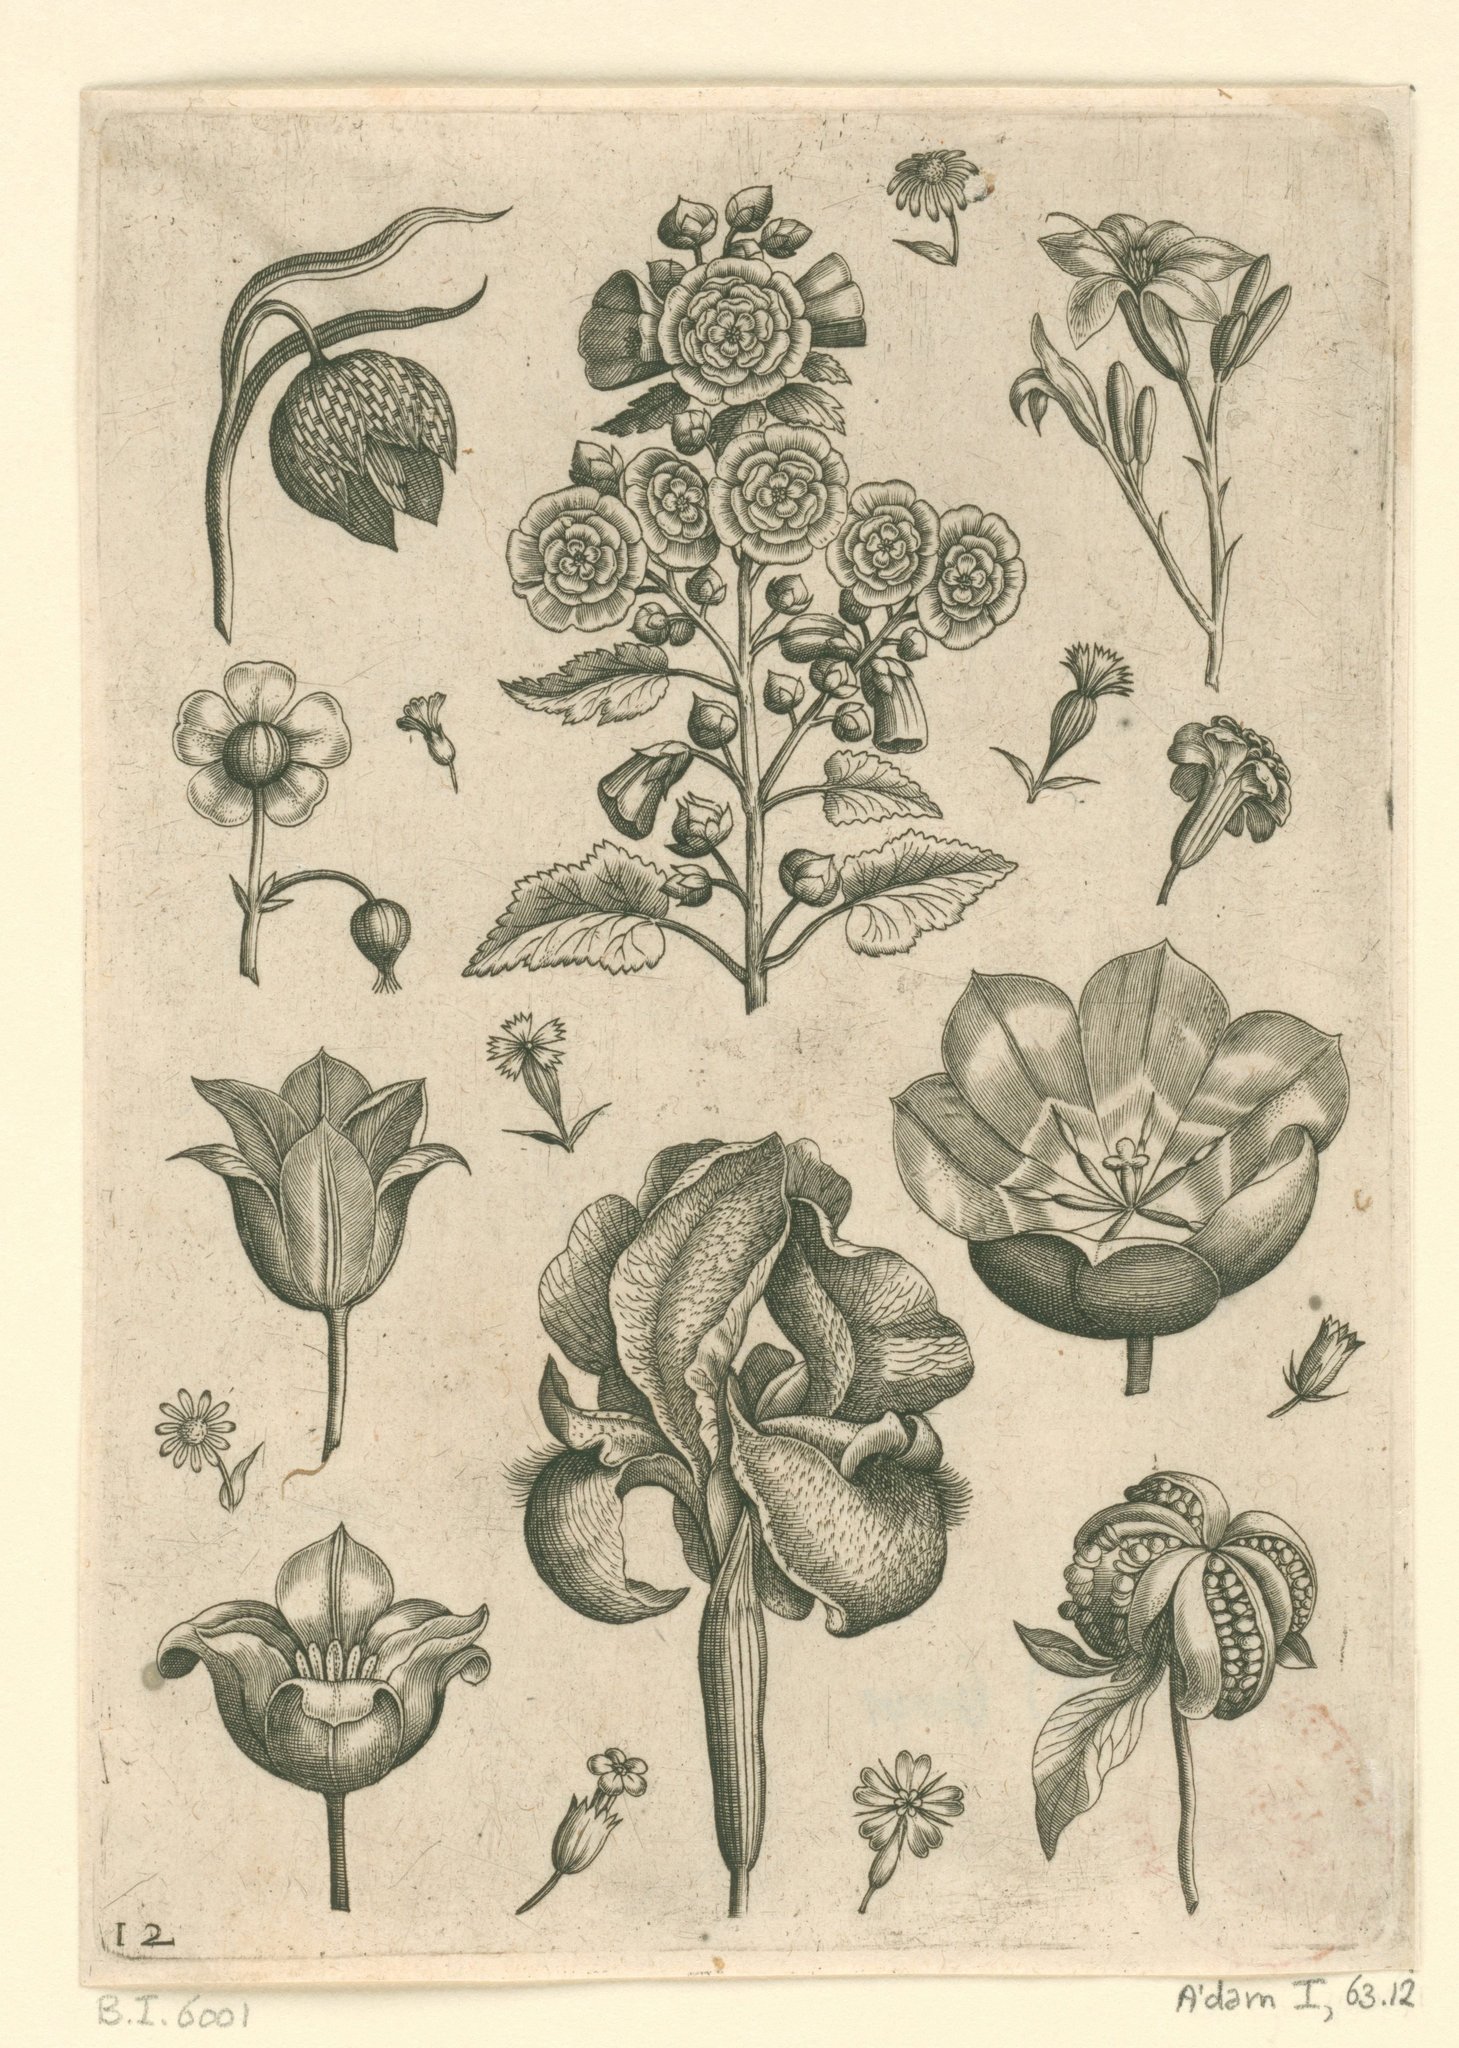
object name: print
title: Florilegium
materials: paper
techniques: engraving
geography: netherlands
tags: flowers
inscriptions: collector's mark: Lugt 240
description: Middenonder de bloem van een iris, linksboven het klokje van een kievitsbloem. Rechtsonder het zaaddoosje van een viooltje. Blad 12 van 21 genummerde bladen met titelblad afkomstig uit een serie van 24.